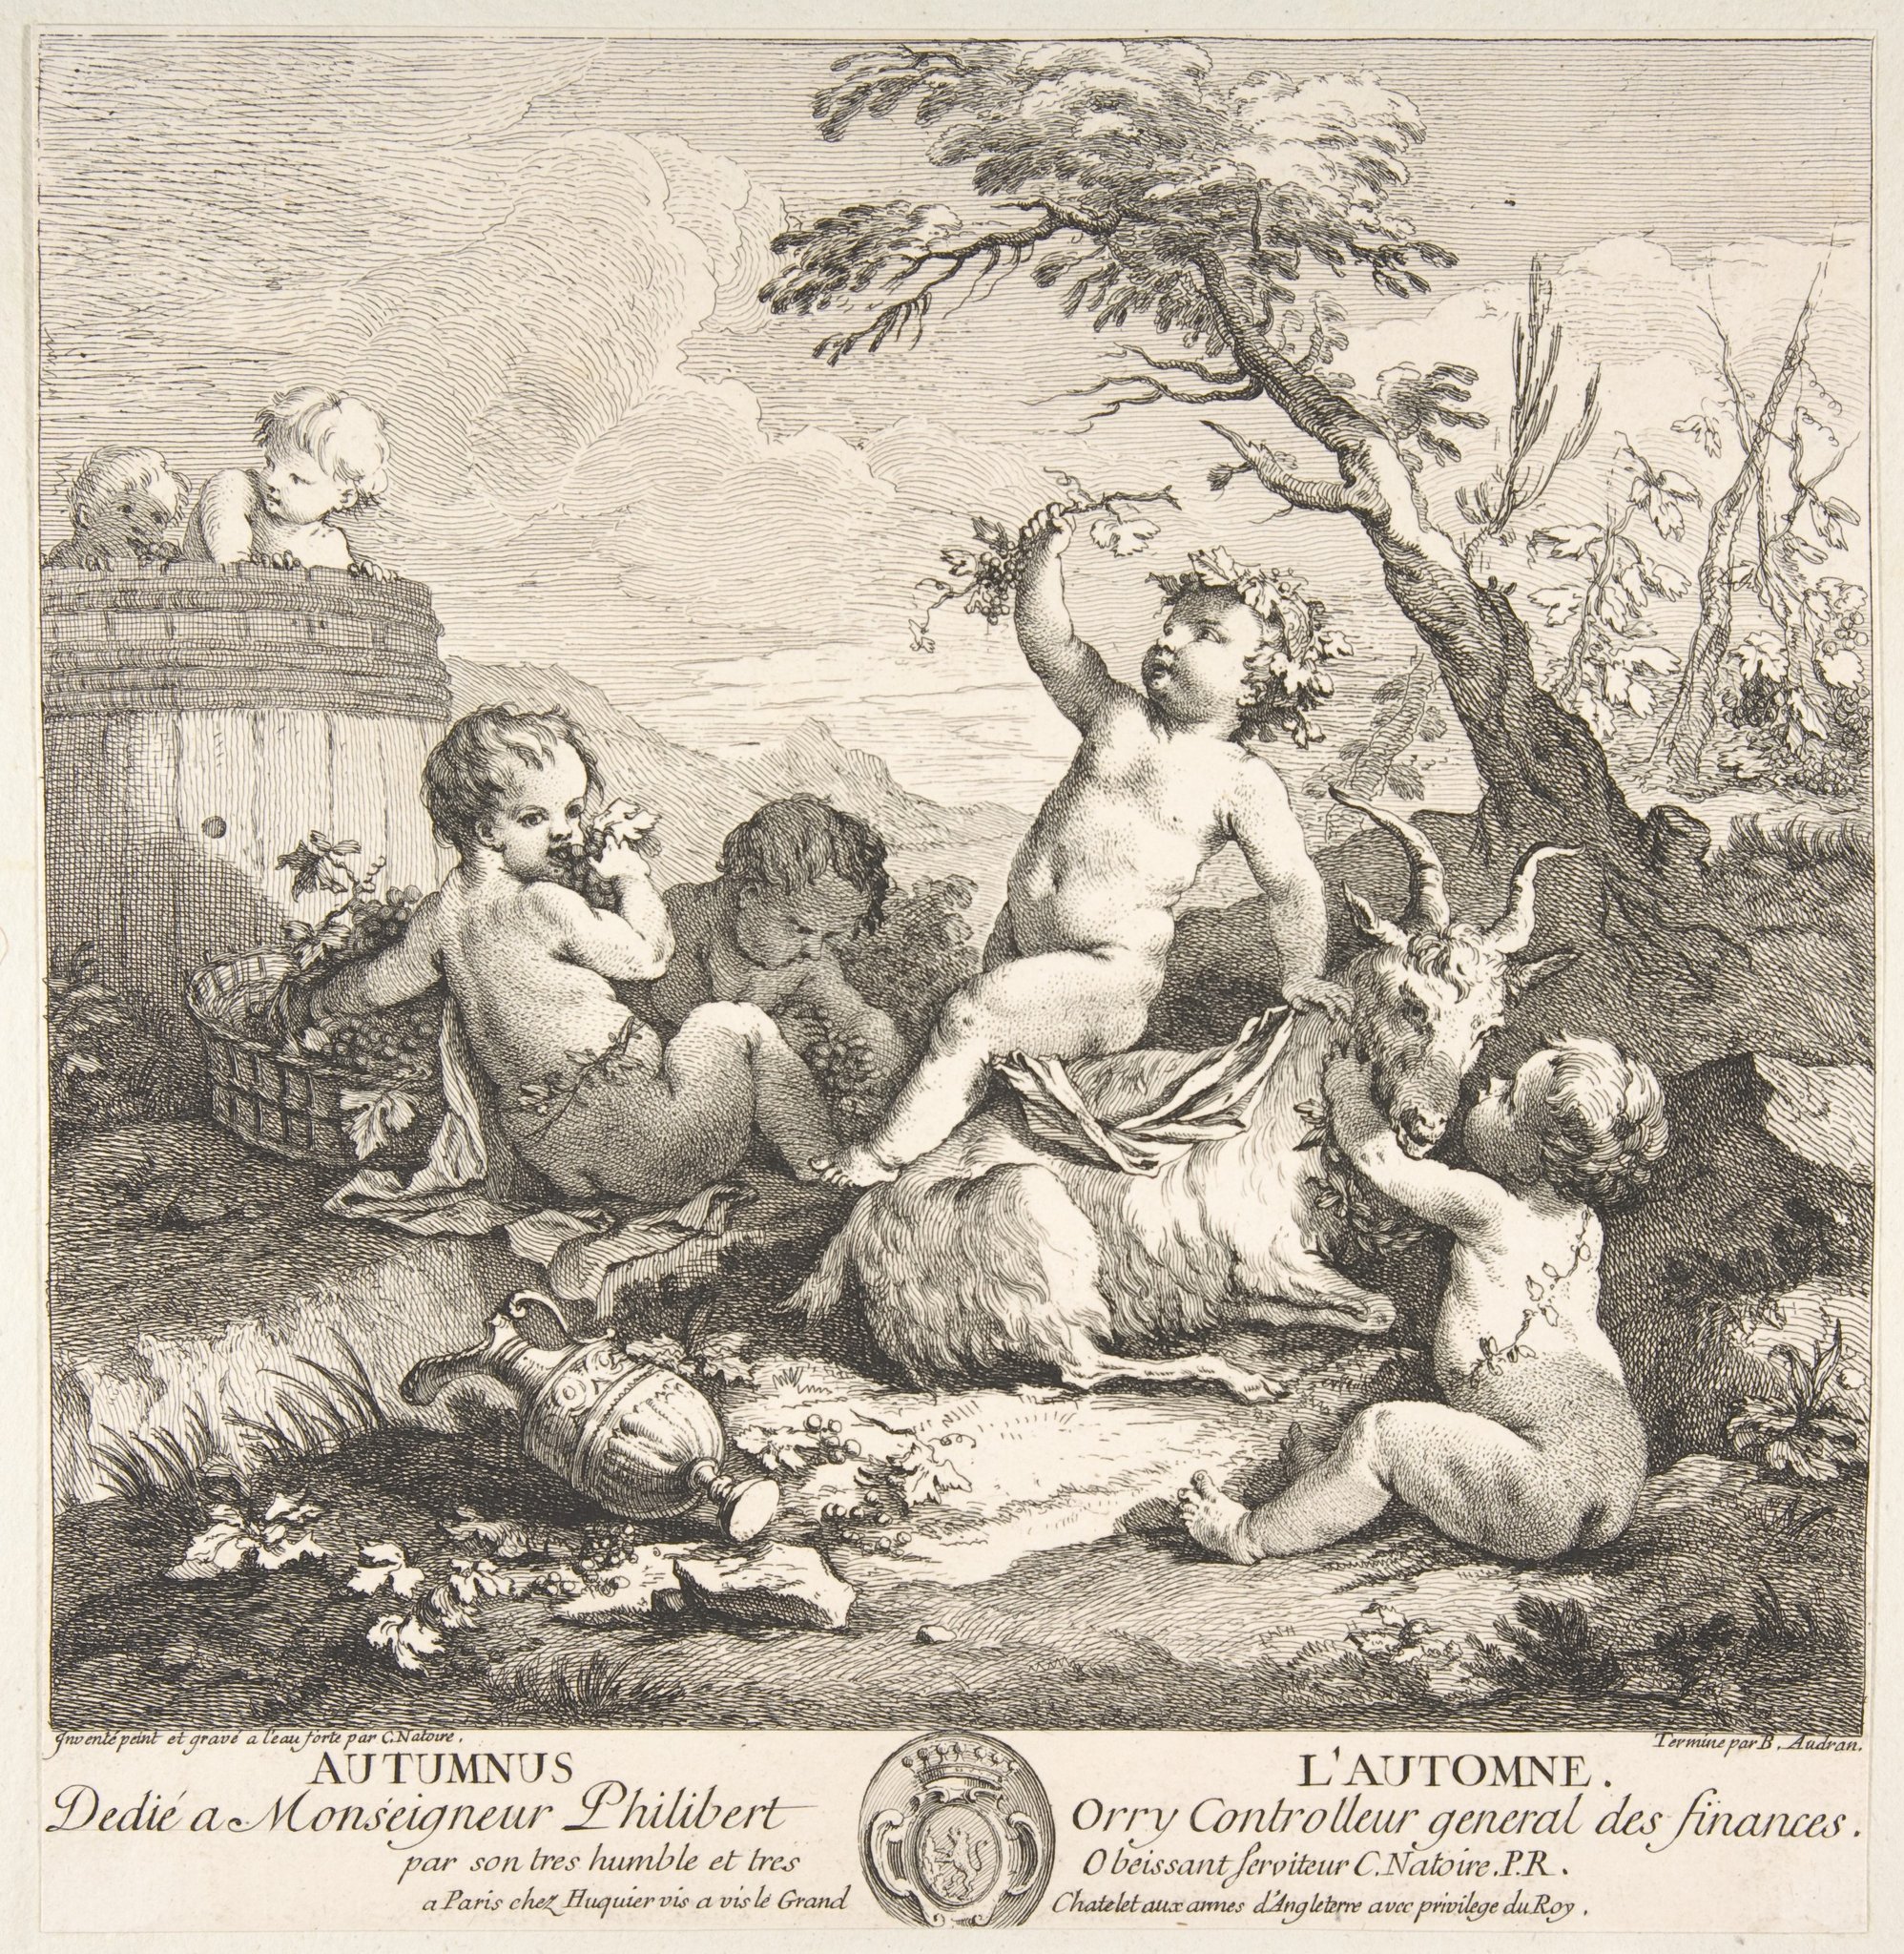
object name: print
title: Fall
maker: charles joseph natoire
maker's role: artist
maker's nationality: french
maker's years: 1700-1777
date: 1730-1760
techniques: engraving, etching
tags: animals,grapes,children,trees,autumn